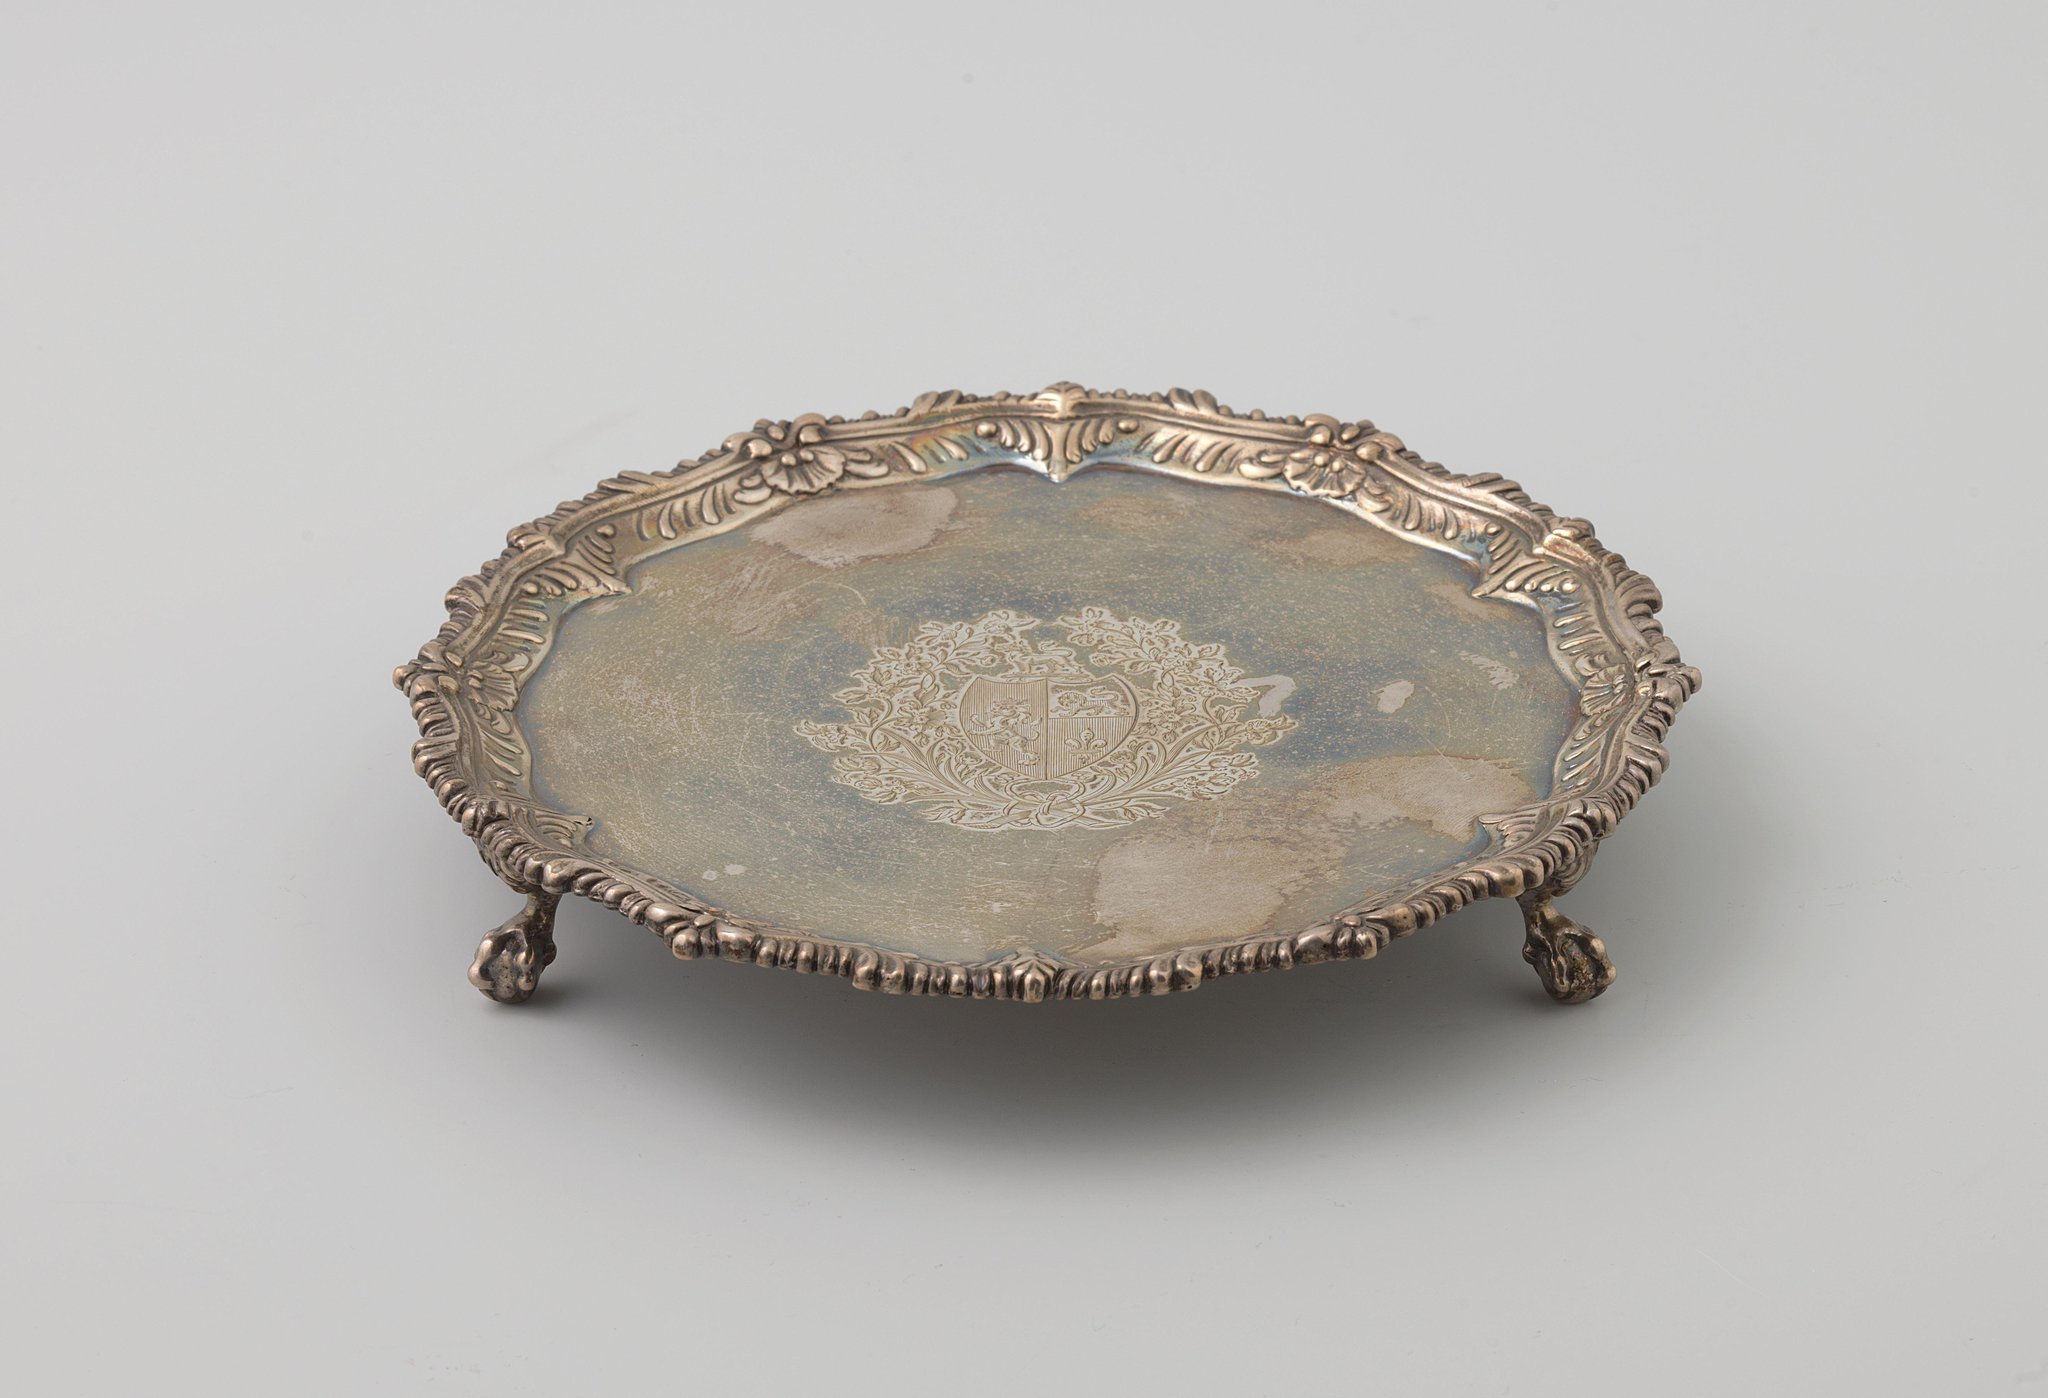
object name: salver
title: Presenteerblad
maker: robert rew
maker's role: silversmith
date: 1771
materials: silver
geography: london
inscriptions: inscription: ‘N. Hayward’, mark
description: Presenteerblad van zilver, met accoladevormig geschulpte rand. Het blad staat op 3 klauwpootjes. Op het plat is een wapenschild gegraveerd in een krans van gekruiste bloemtakken.